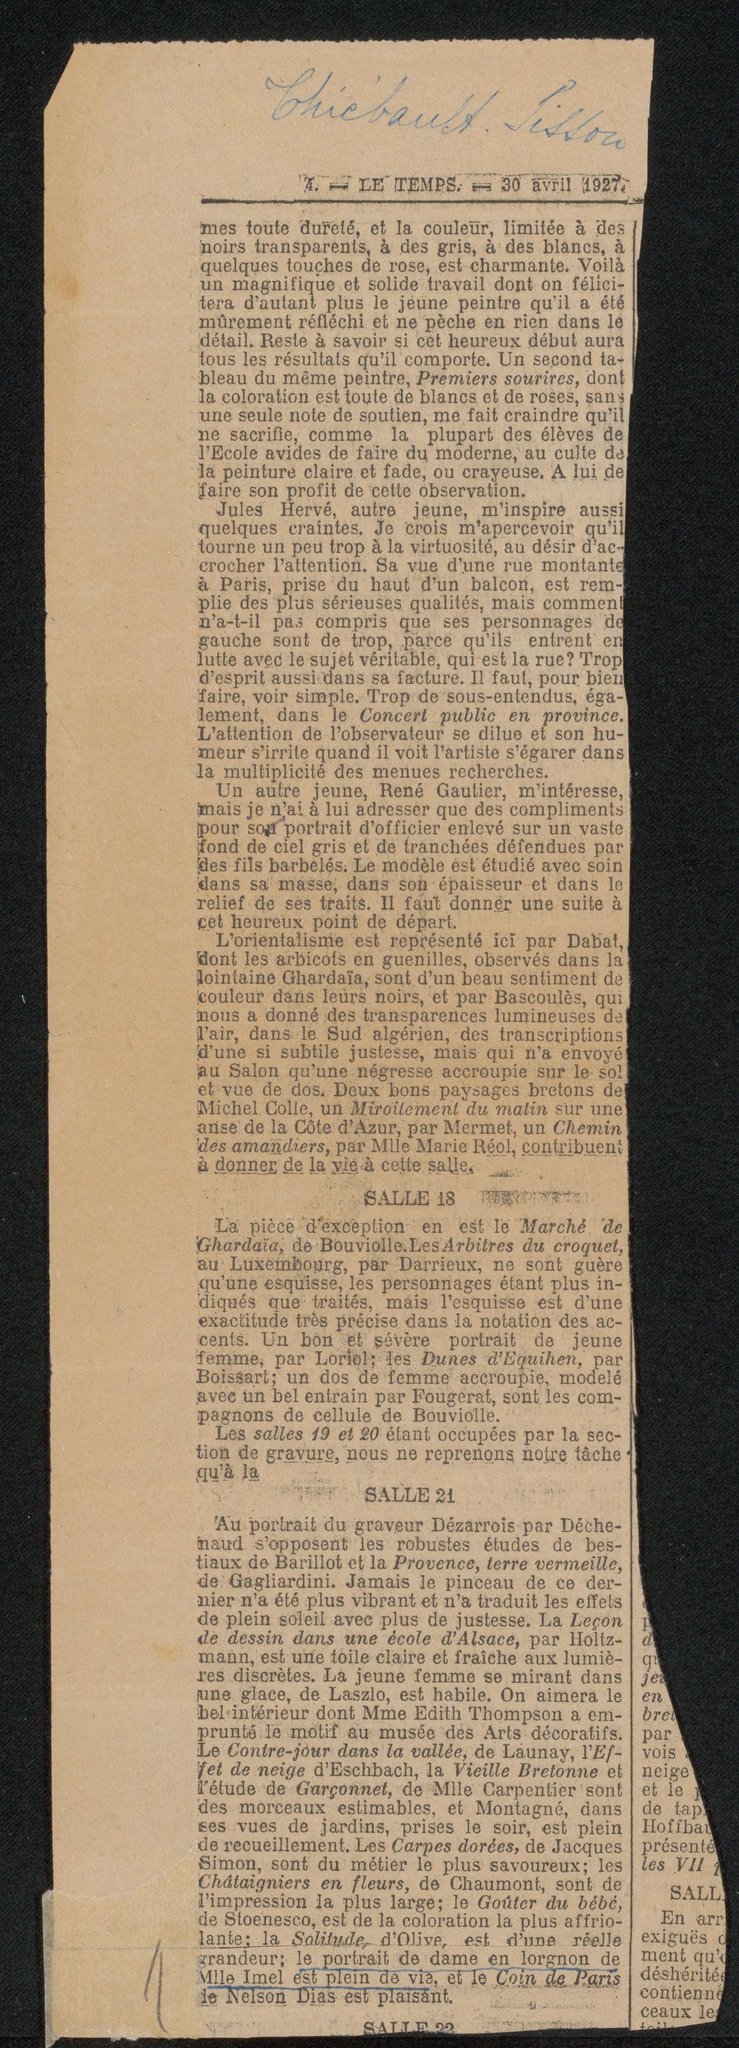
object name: newspaper clipping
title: Krantenknipsel uit archief Philip Zilcken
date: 1924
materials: paper, ink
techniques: pen, printing, writing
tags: rose imel, painter, draughtsman, philip zilcken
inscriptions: collector's mark: ‘RPK’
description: Krantenknipsel vormt bijlage bij brief RP-D-1982-43-IMEL-160.